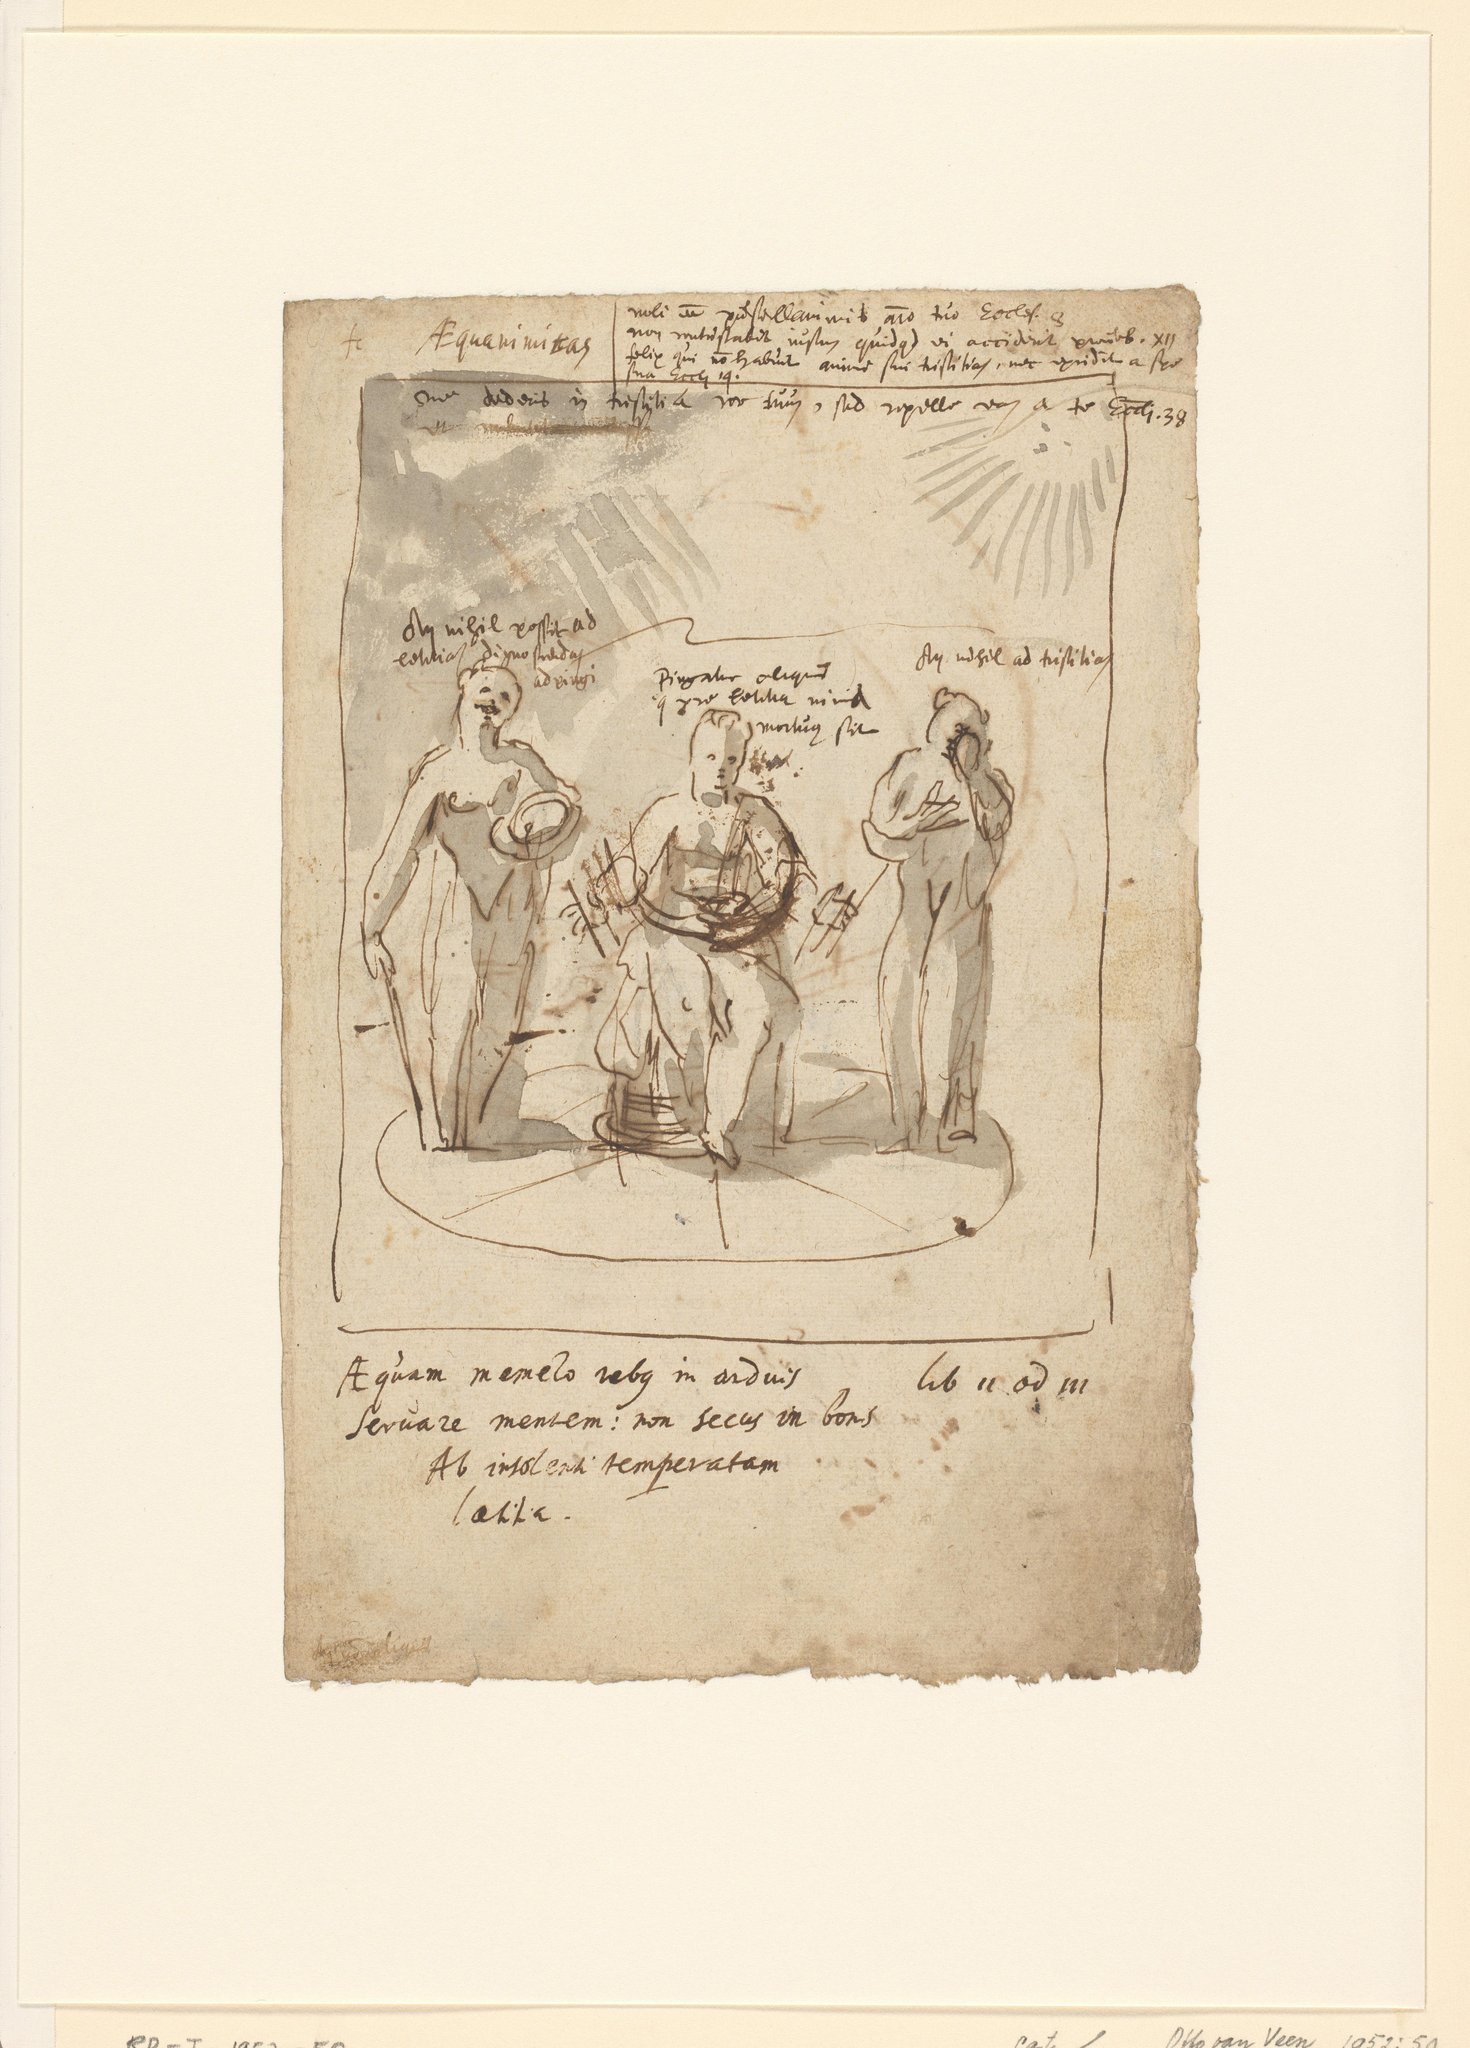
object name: drawing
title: Ontwerp voor Horatiaans Emblemata: Aequanimitas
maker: otto van veen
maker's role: draughtsman, painter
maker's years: 1556-1629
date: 1599-1609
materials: ink, paper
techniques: brush, pen